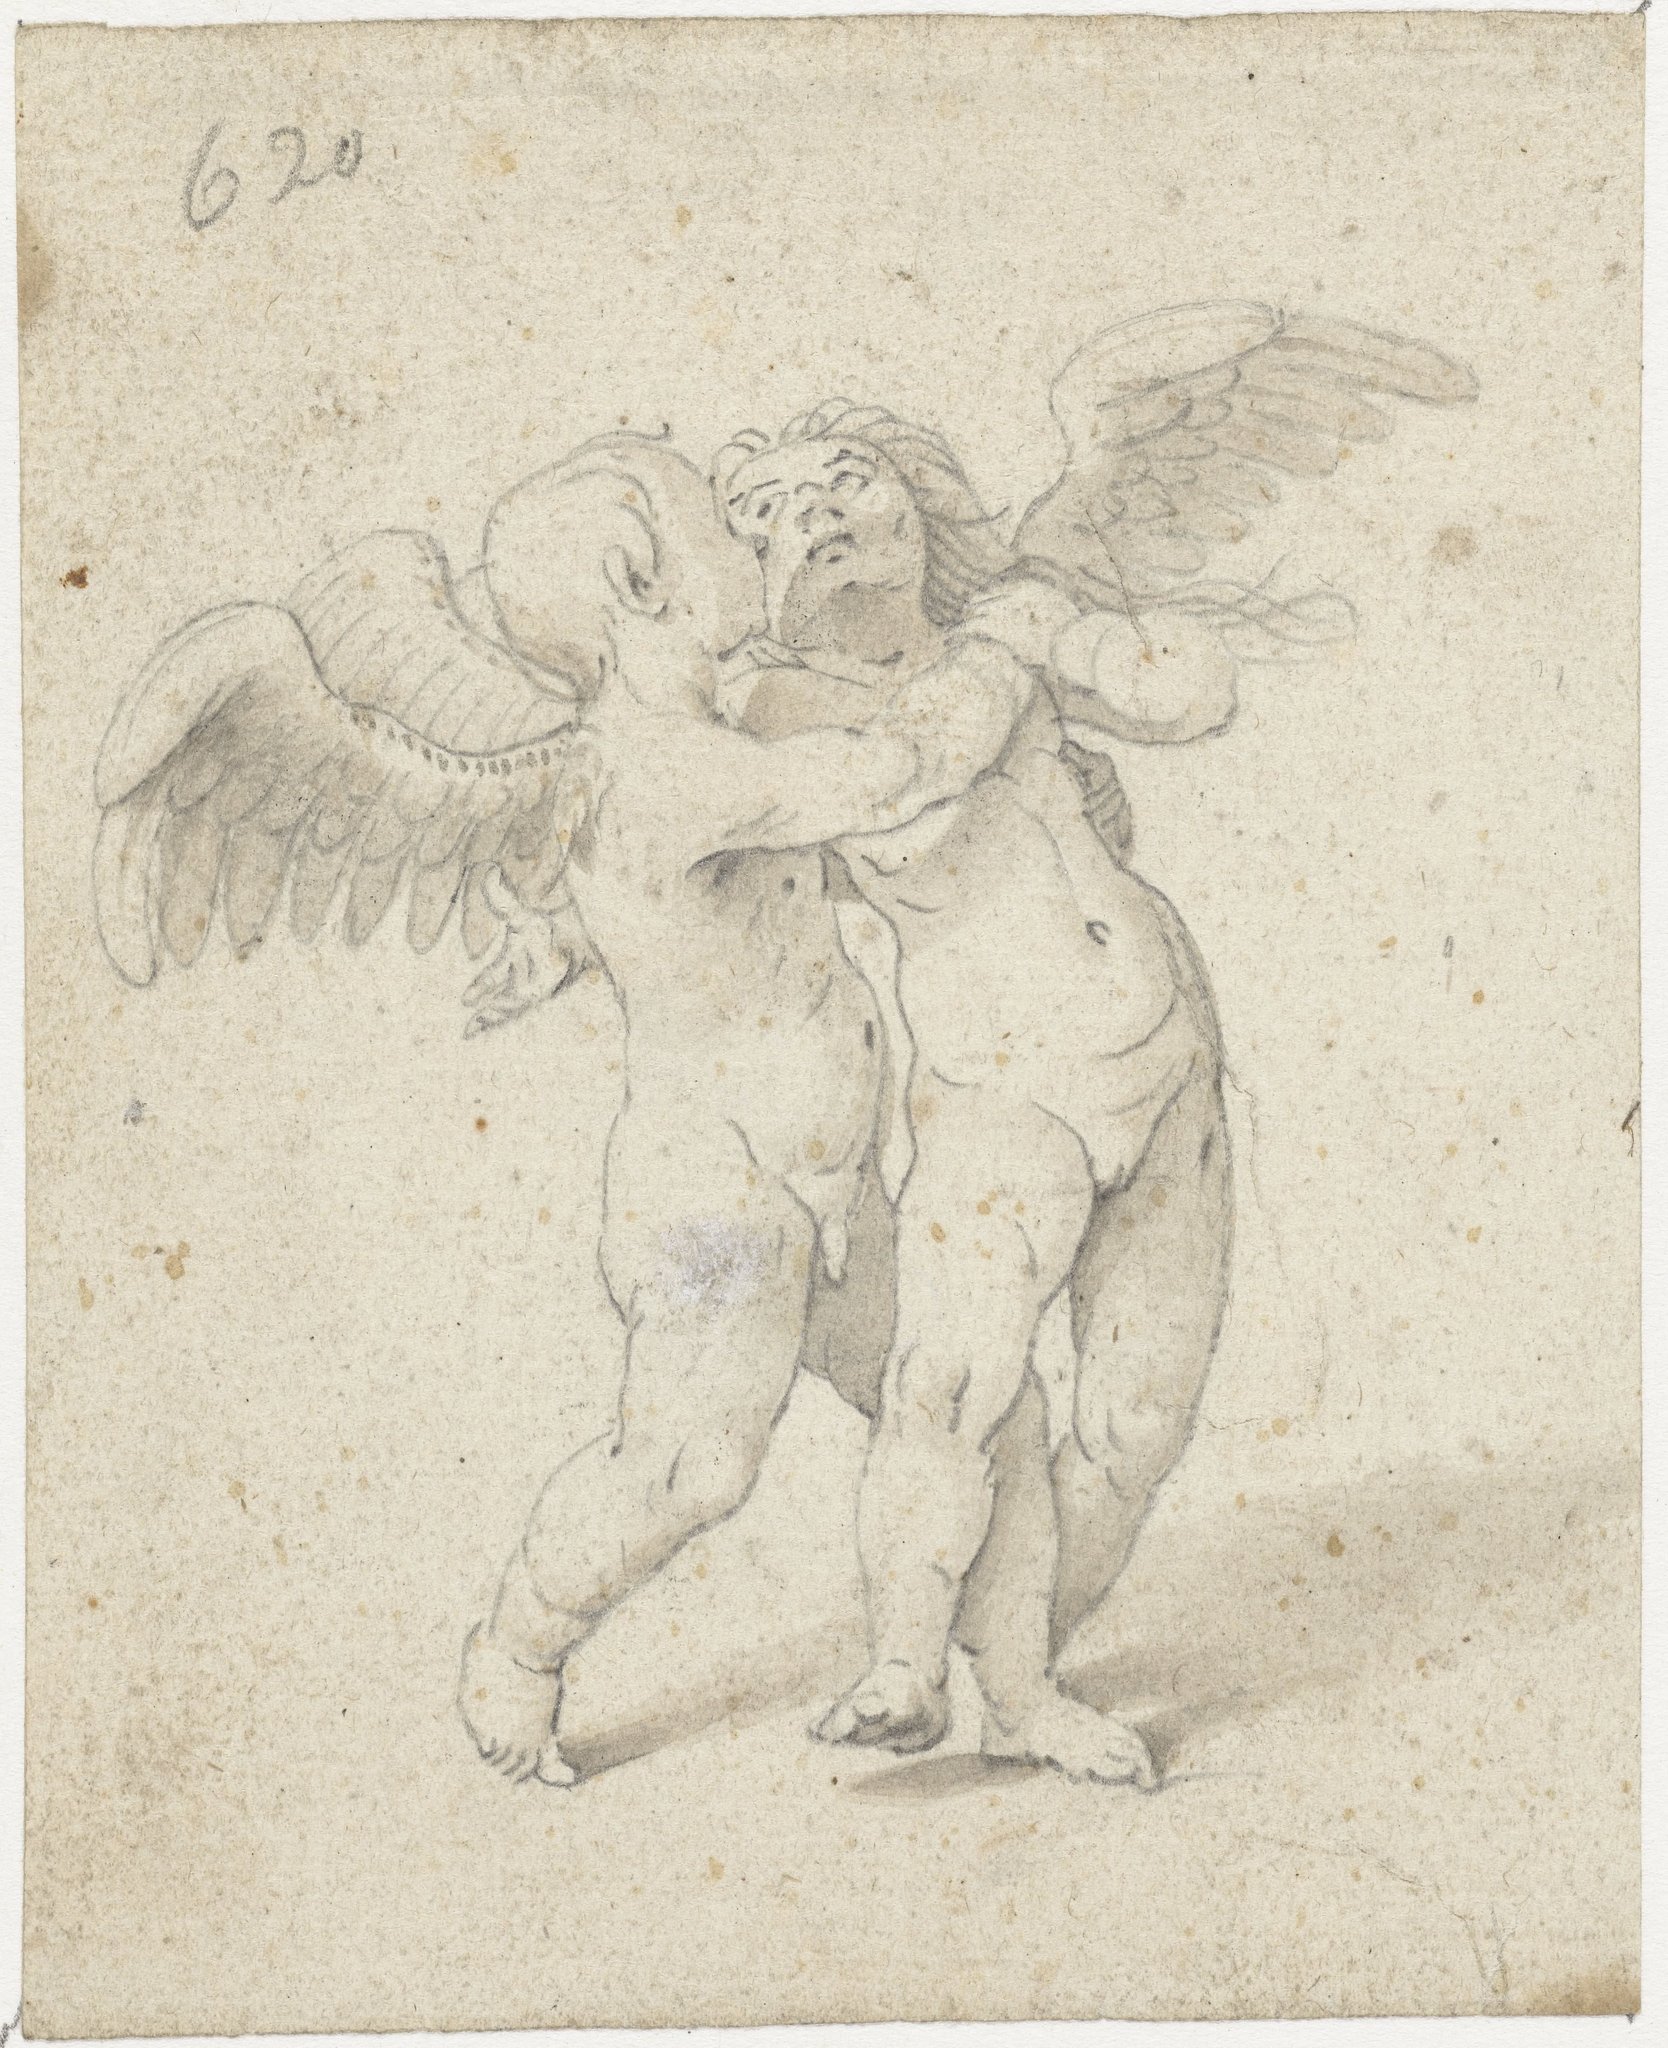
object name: drawing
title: Twee worstelende engelen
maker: gerard ter borch (i)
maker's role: draughtsman, print maker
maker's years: 1584-1662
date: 1615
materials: ink, paper, pencil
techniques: brush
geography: zwolle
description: Twee worstelende engelen. Waarschijnlijk de aardse en de hemelse liefde (Eros en Anteros?).